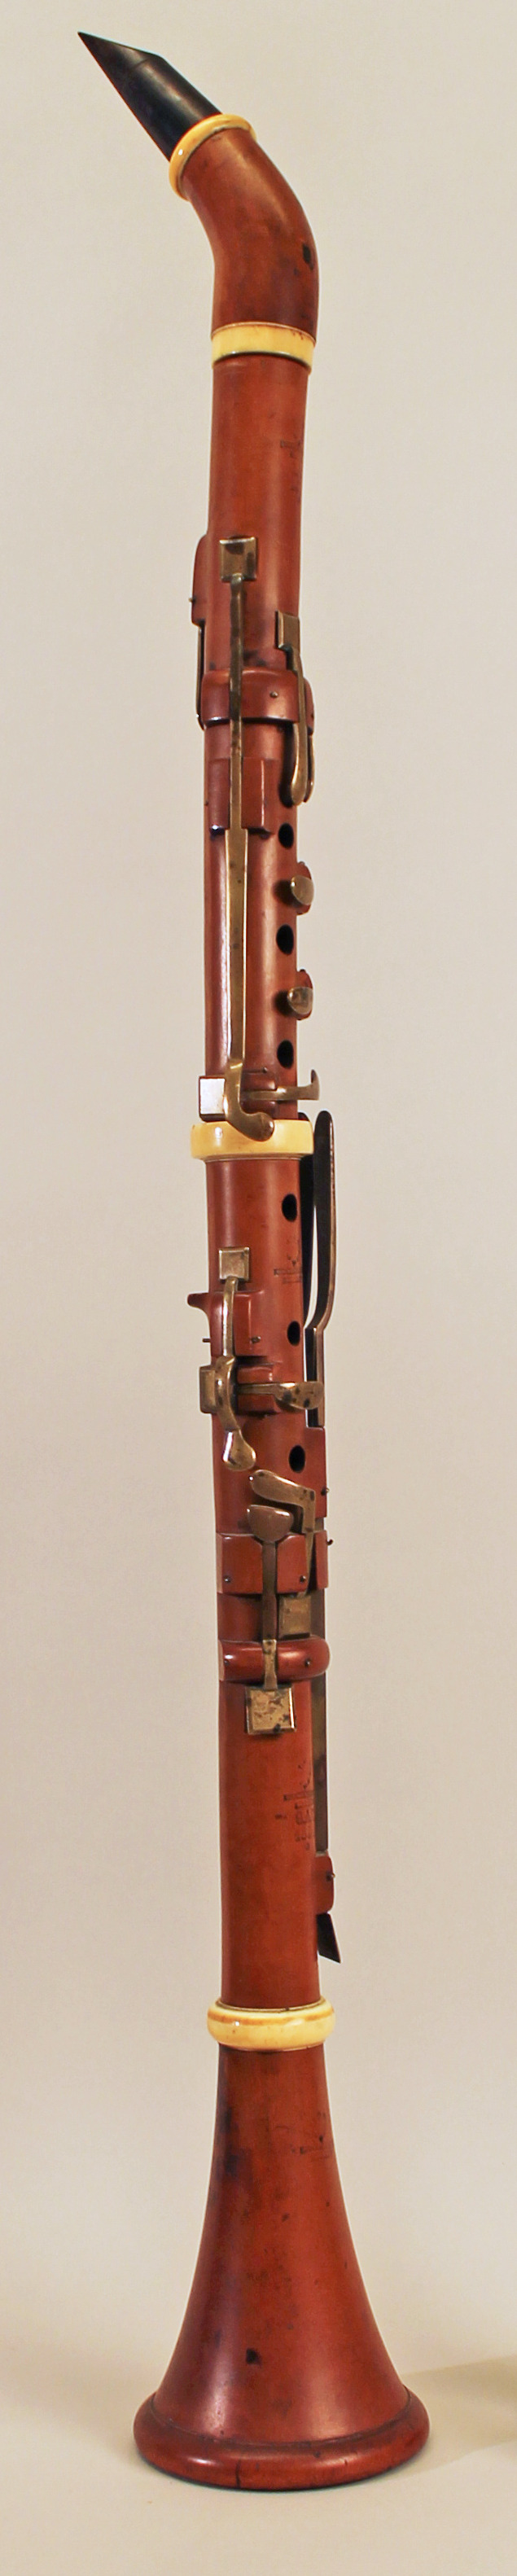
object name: clarinet in f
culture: german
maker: august t. a. knochenhauer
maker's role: maker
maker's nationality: german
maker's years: 1796-1866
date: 1856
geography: germany